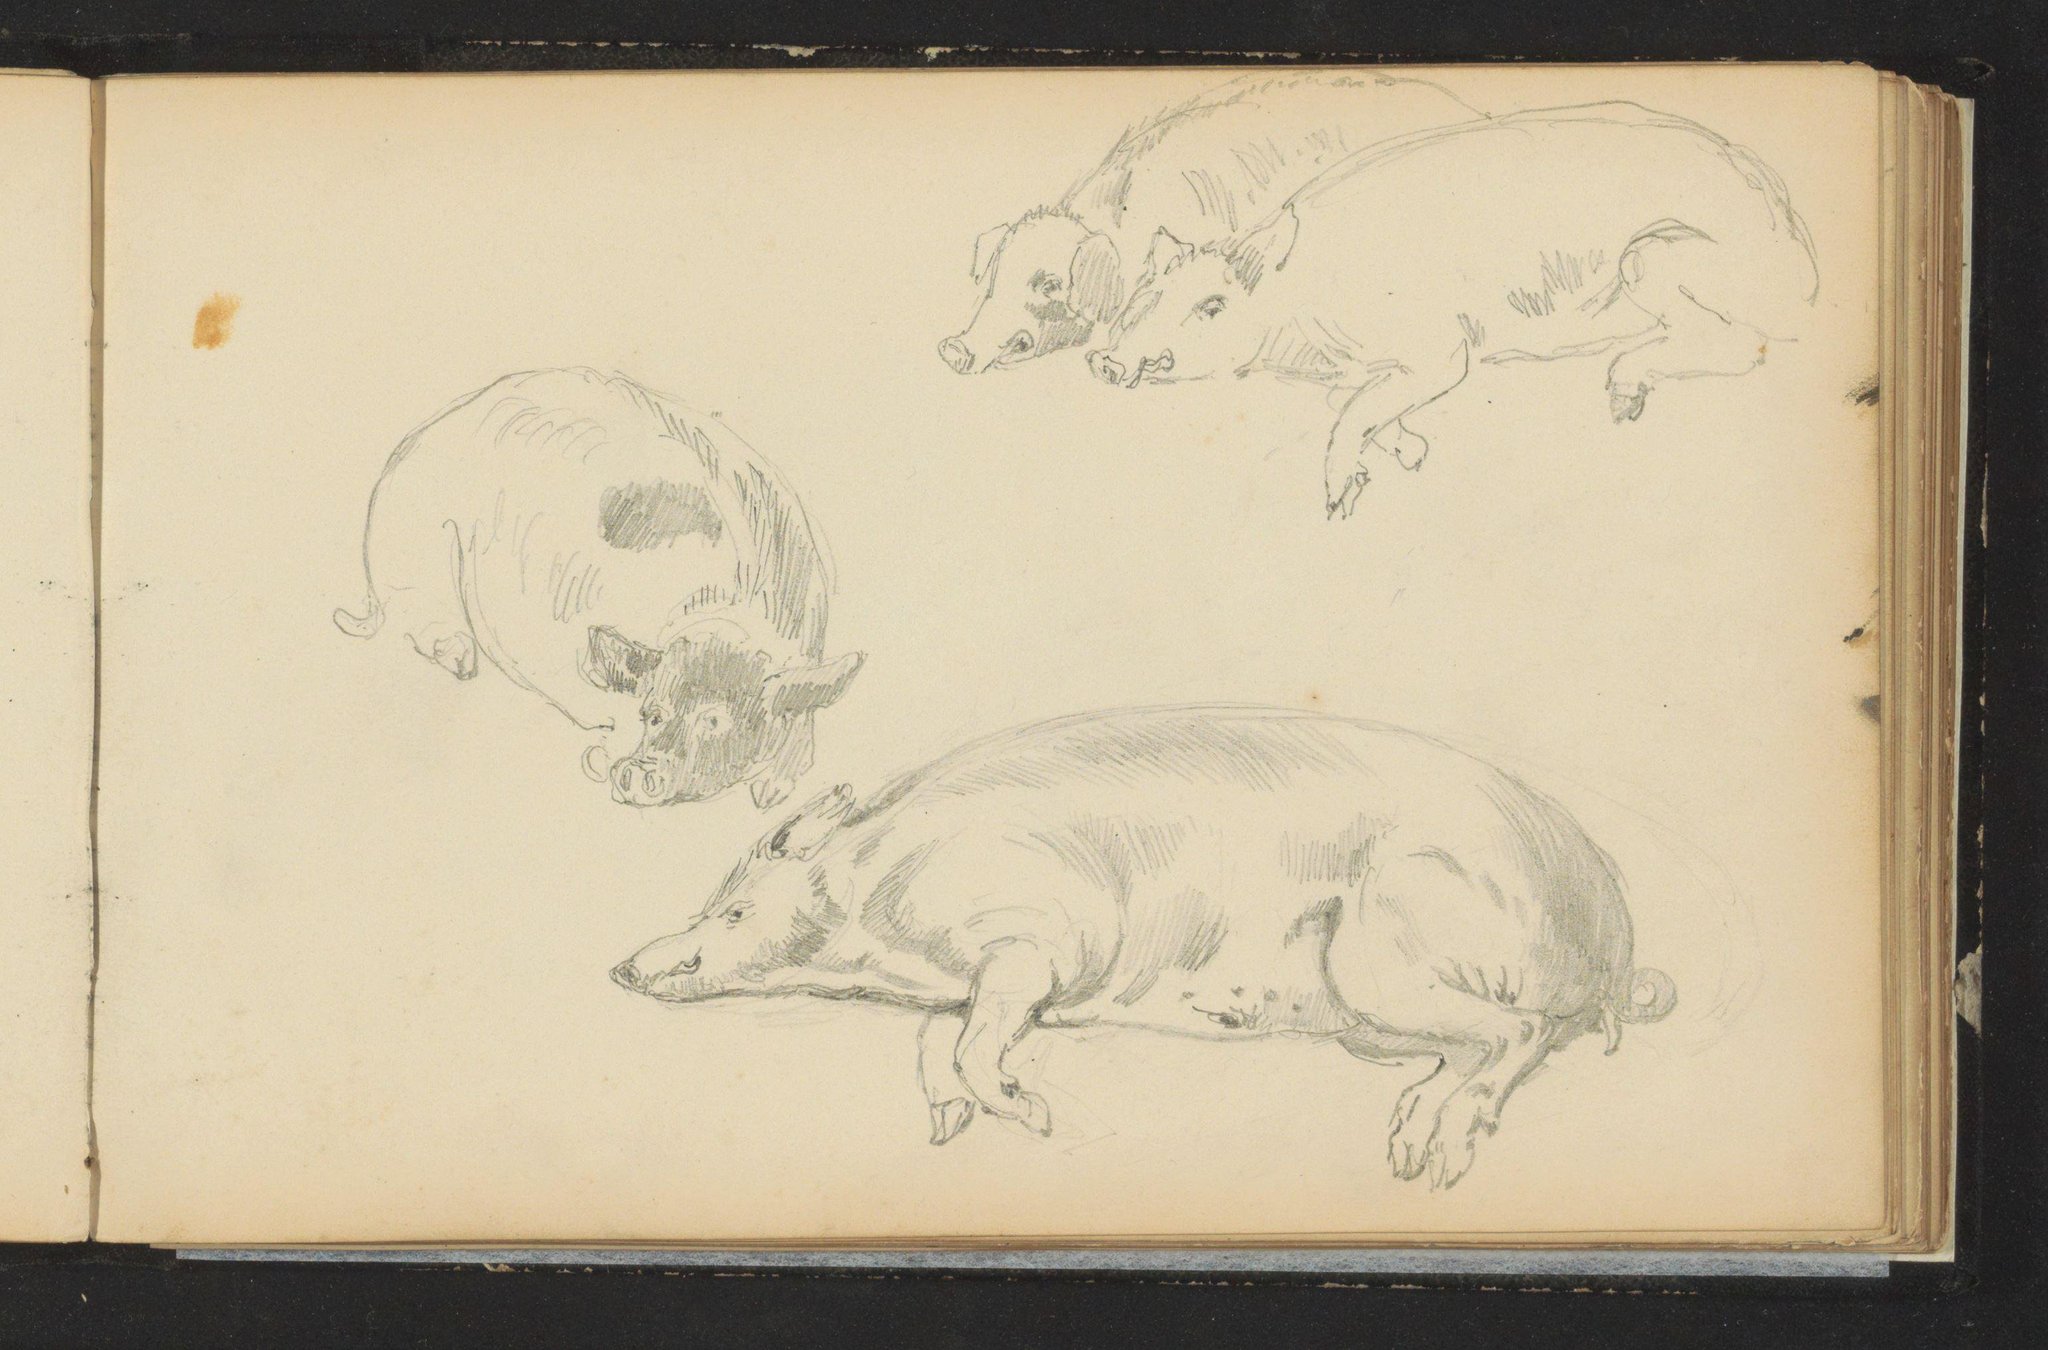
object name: sketchbook leaf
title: Liggende varkens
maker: cornelis springer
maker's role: draughtsman, painter, print maker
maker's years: 1817-1891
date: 1846-1882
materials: paper, pencil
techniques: stumping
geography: netherlands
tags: pig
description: Liggende varkens. Blad 42 uit een schetsboek met 91 bladen.